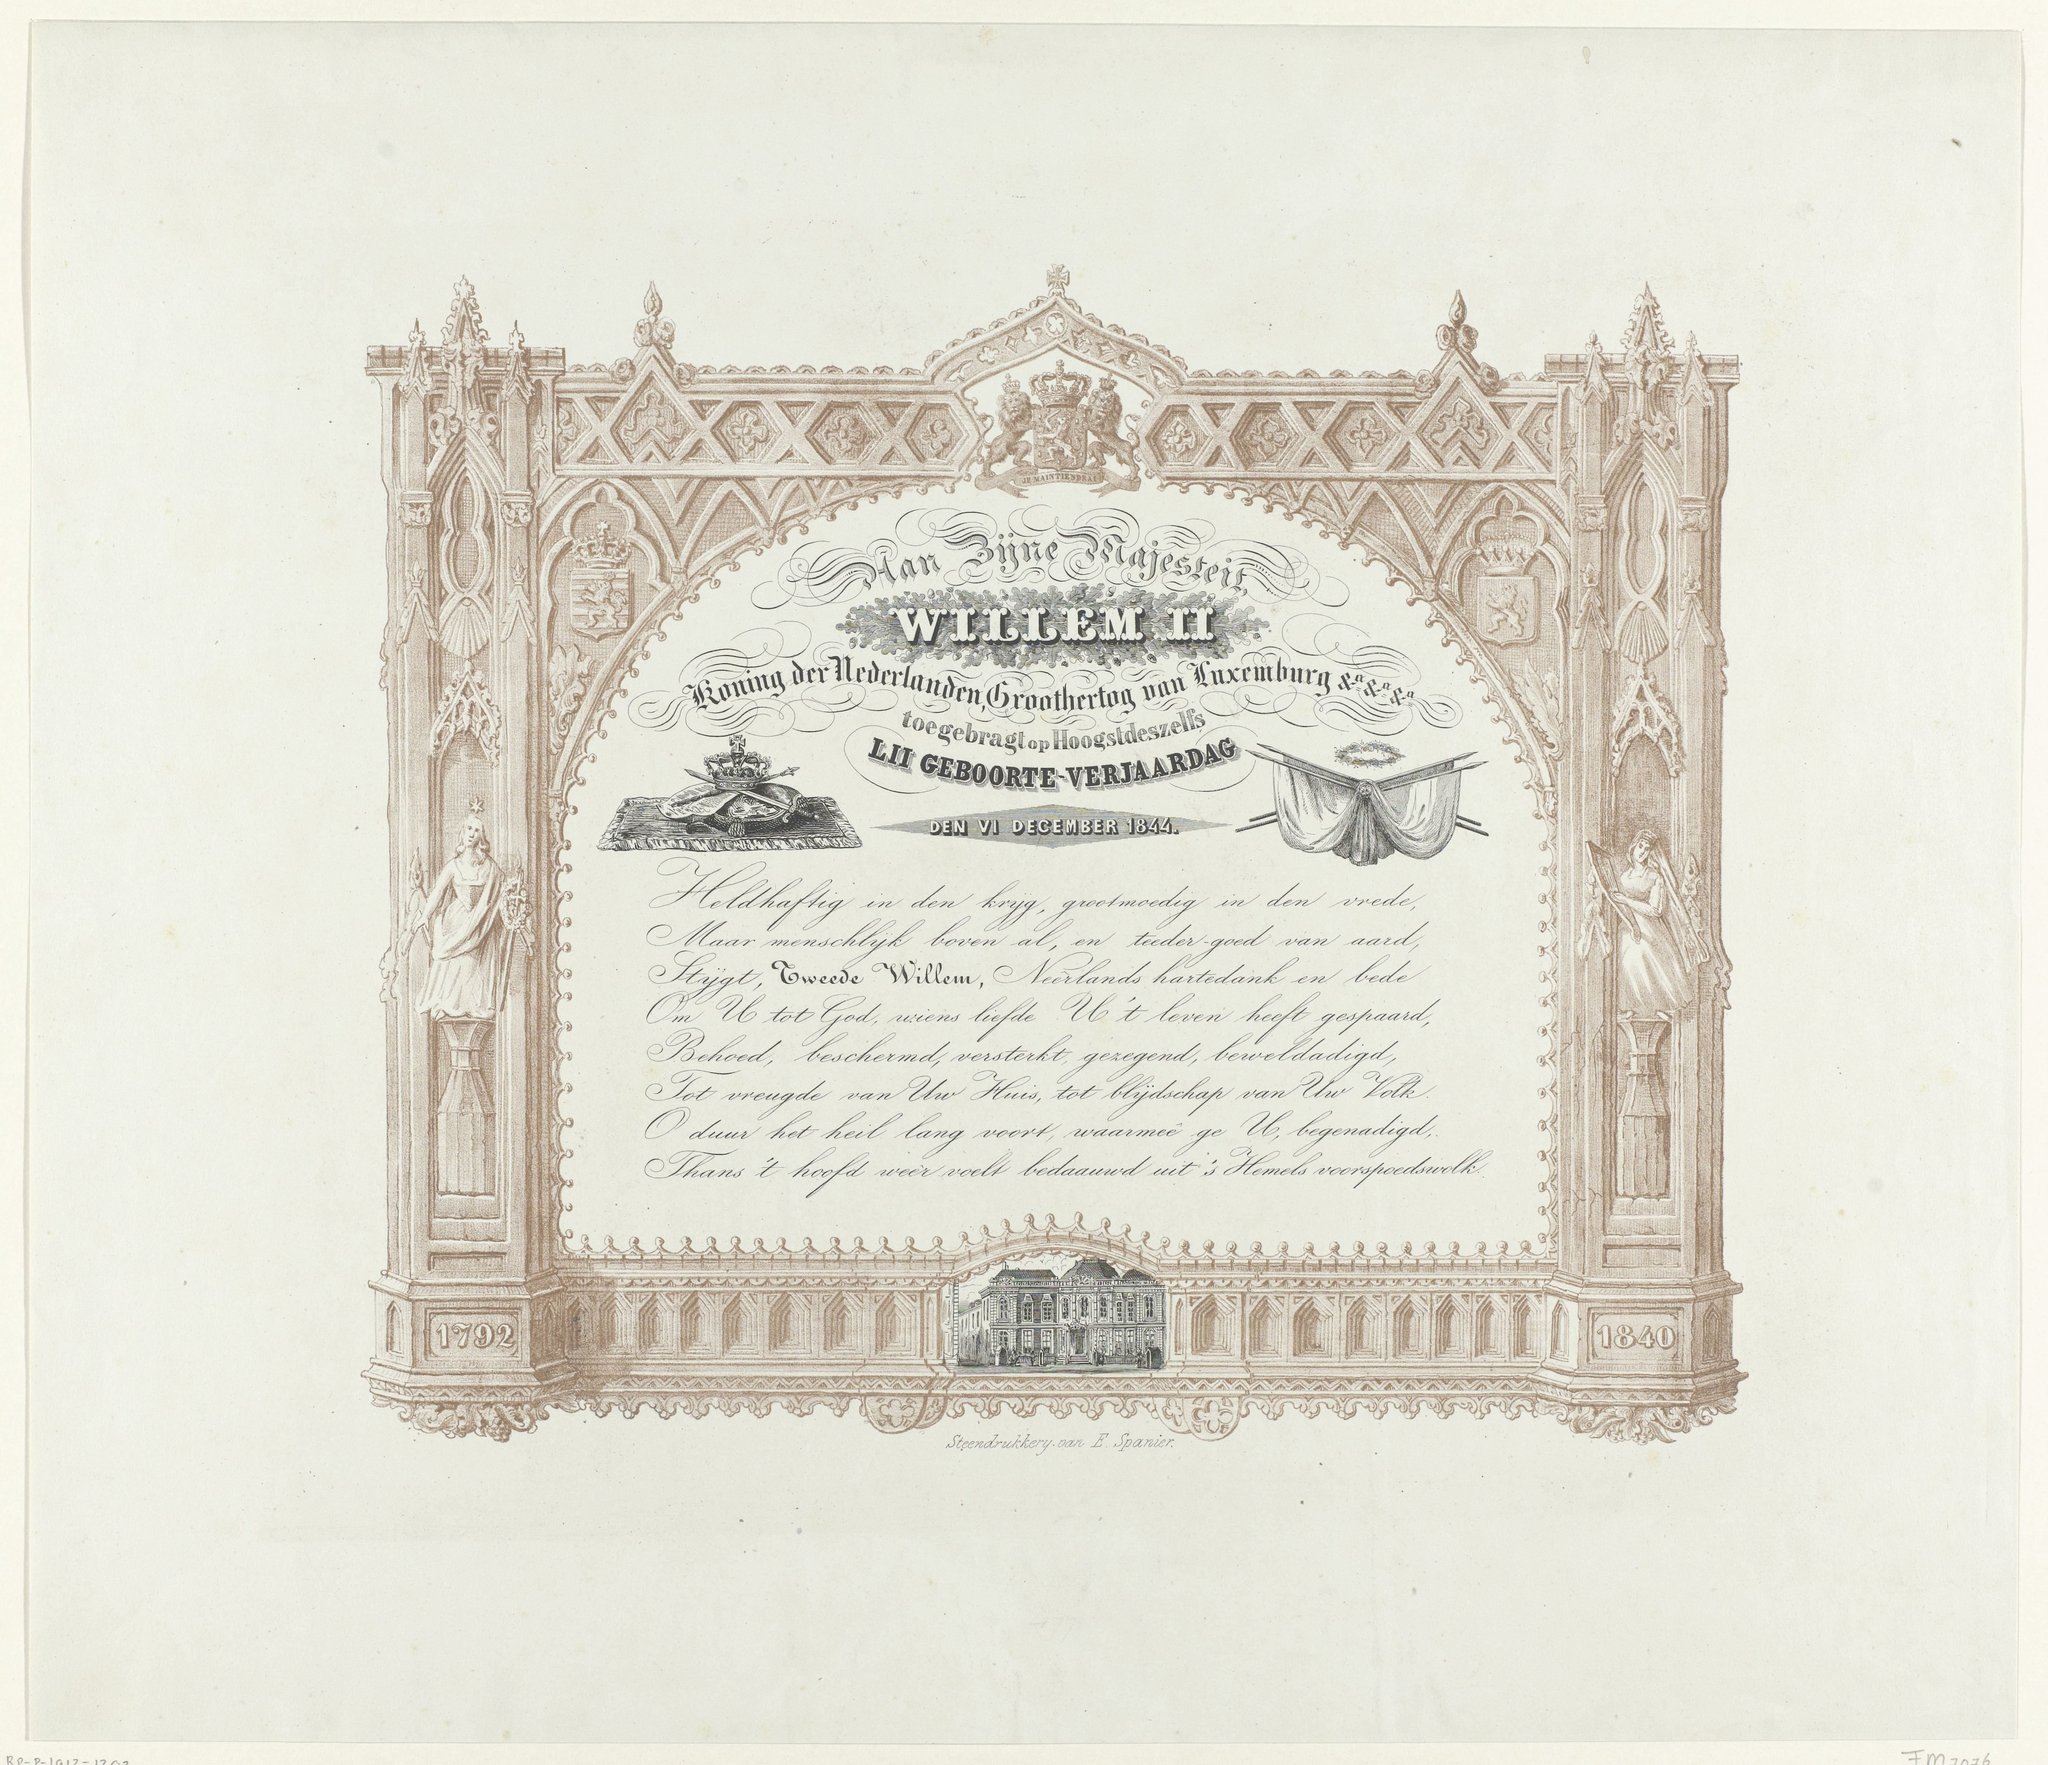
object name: print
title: Aan Zijne Majesteit, Willem II Koning der Nederlanden, Groothertog van Luxumburg &&& toegebragt op Hoogstdeszelfs LII Geboorte-Verjaardag den VI December 1844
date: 1844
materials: paper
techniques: printing, lithograph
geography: netherlands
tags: the hague, william ii of the netherlands, birthday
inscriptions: collector's mark: Lugt 2228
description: Gelukwens aan koning Willem II ter gelegenheid van zijn 52ste verjaardag op 6 december 1844. Tekst binnen een omlijsting met gotische decoraties, onderaan een vignet met Paleis Kneuterdijk te Den Haag.